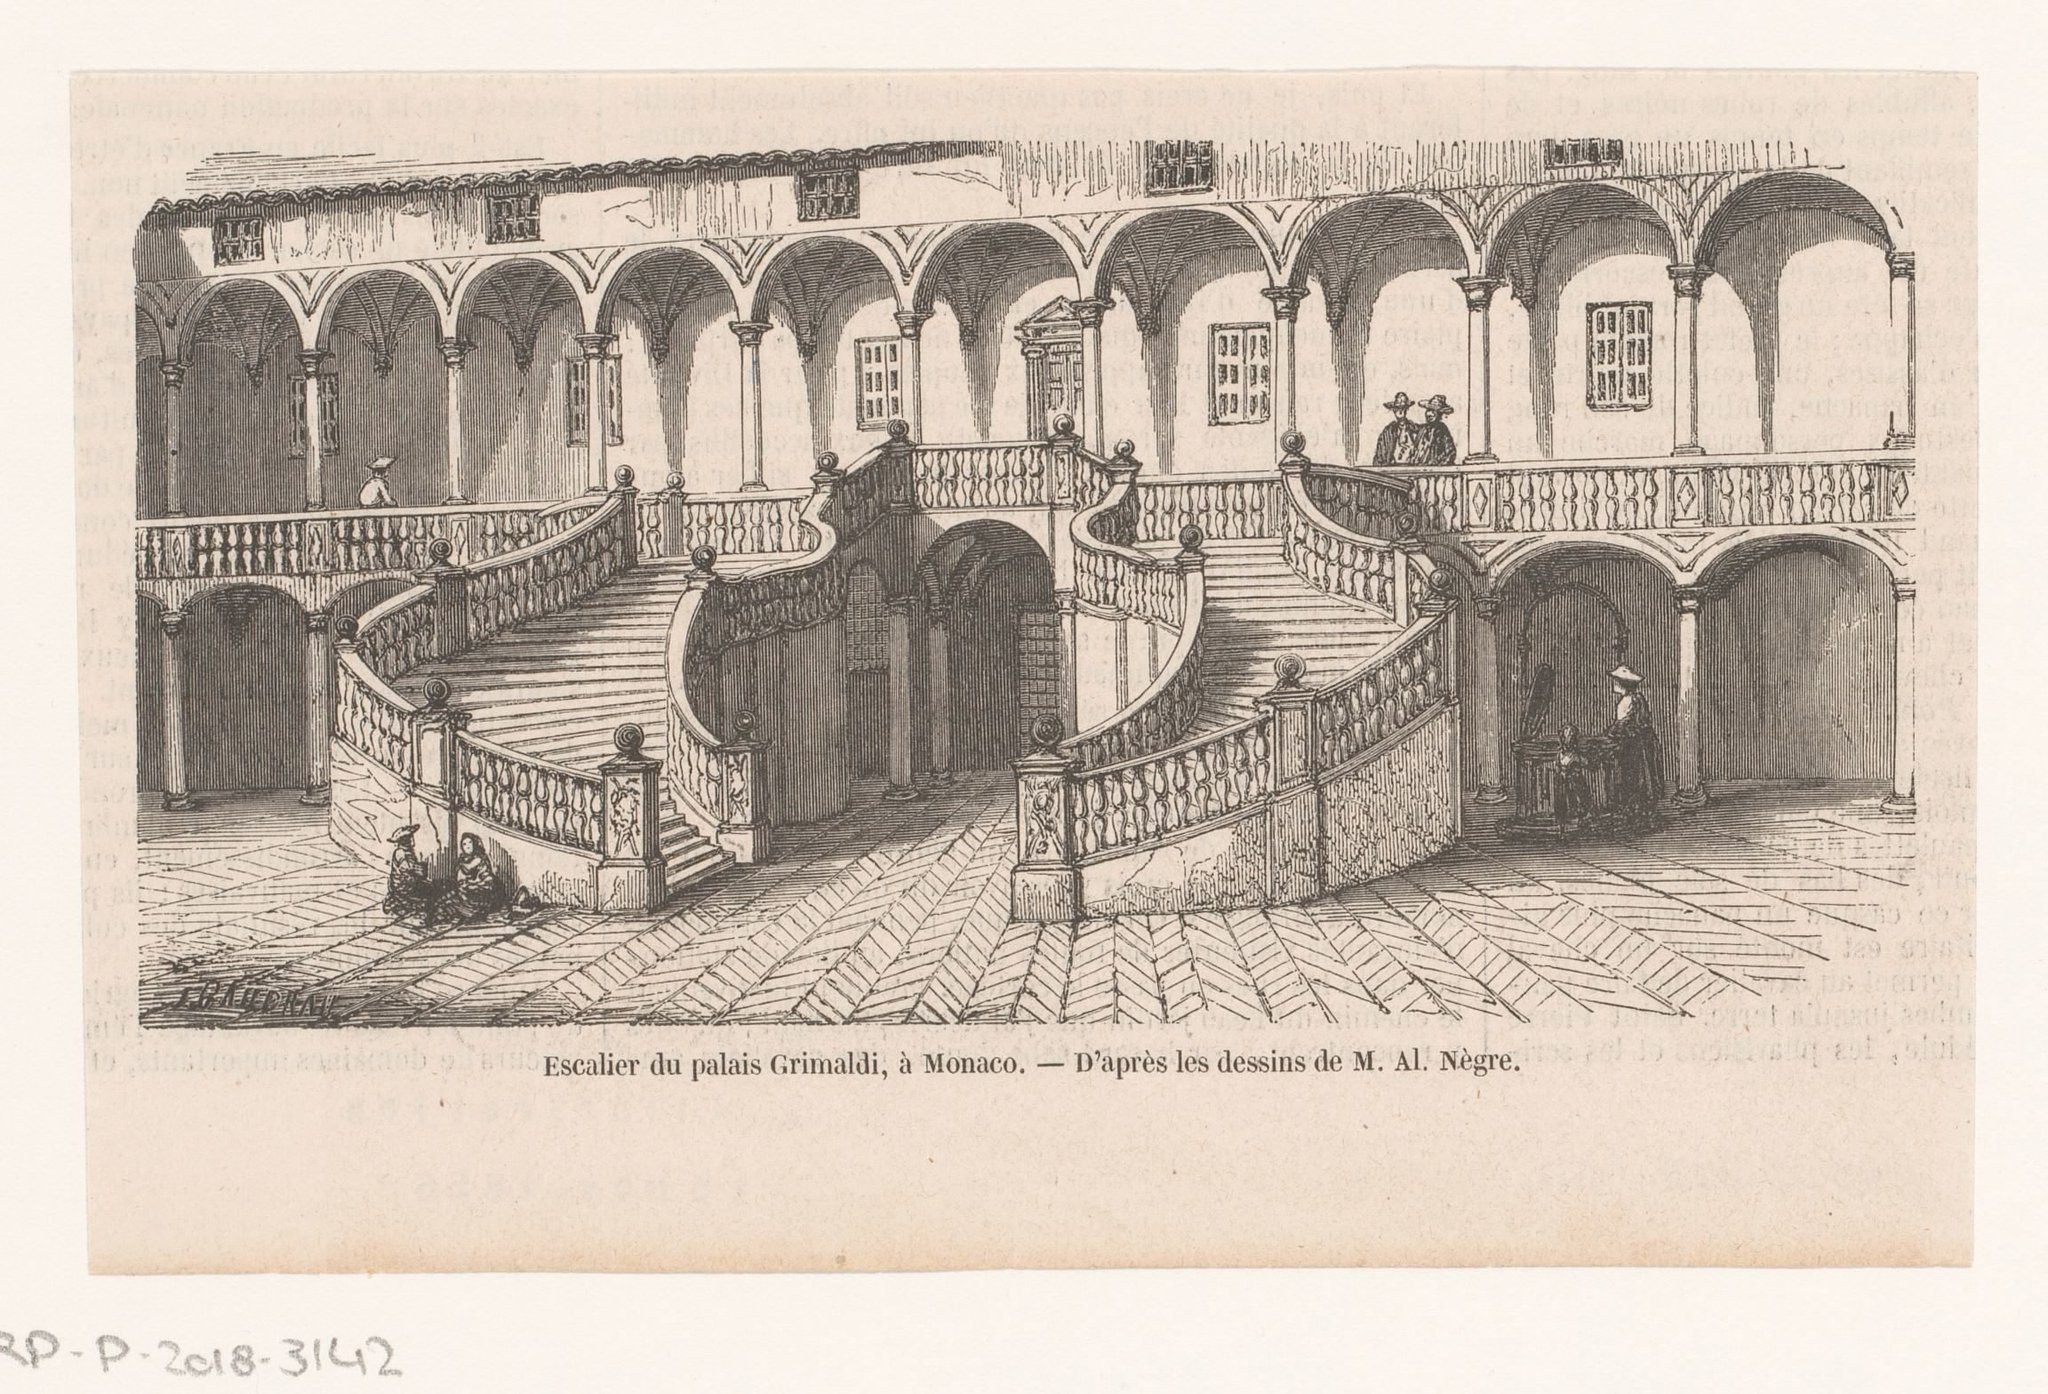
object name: book illustration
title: Trappen voor het prinselijk paleis van Monaco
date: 1856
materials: paper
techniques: letterpress printing, engraving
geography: paris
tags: inner court of palace or 'hôtel'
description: Prent uit: L'Illustration 28 (1856), nr. 716: 15 november 1856, p. 317.